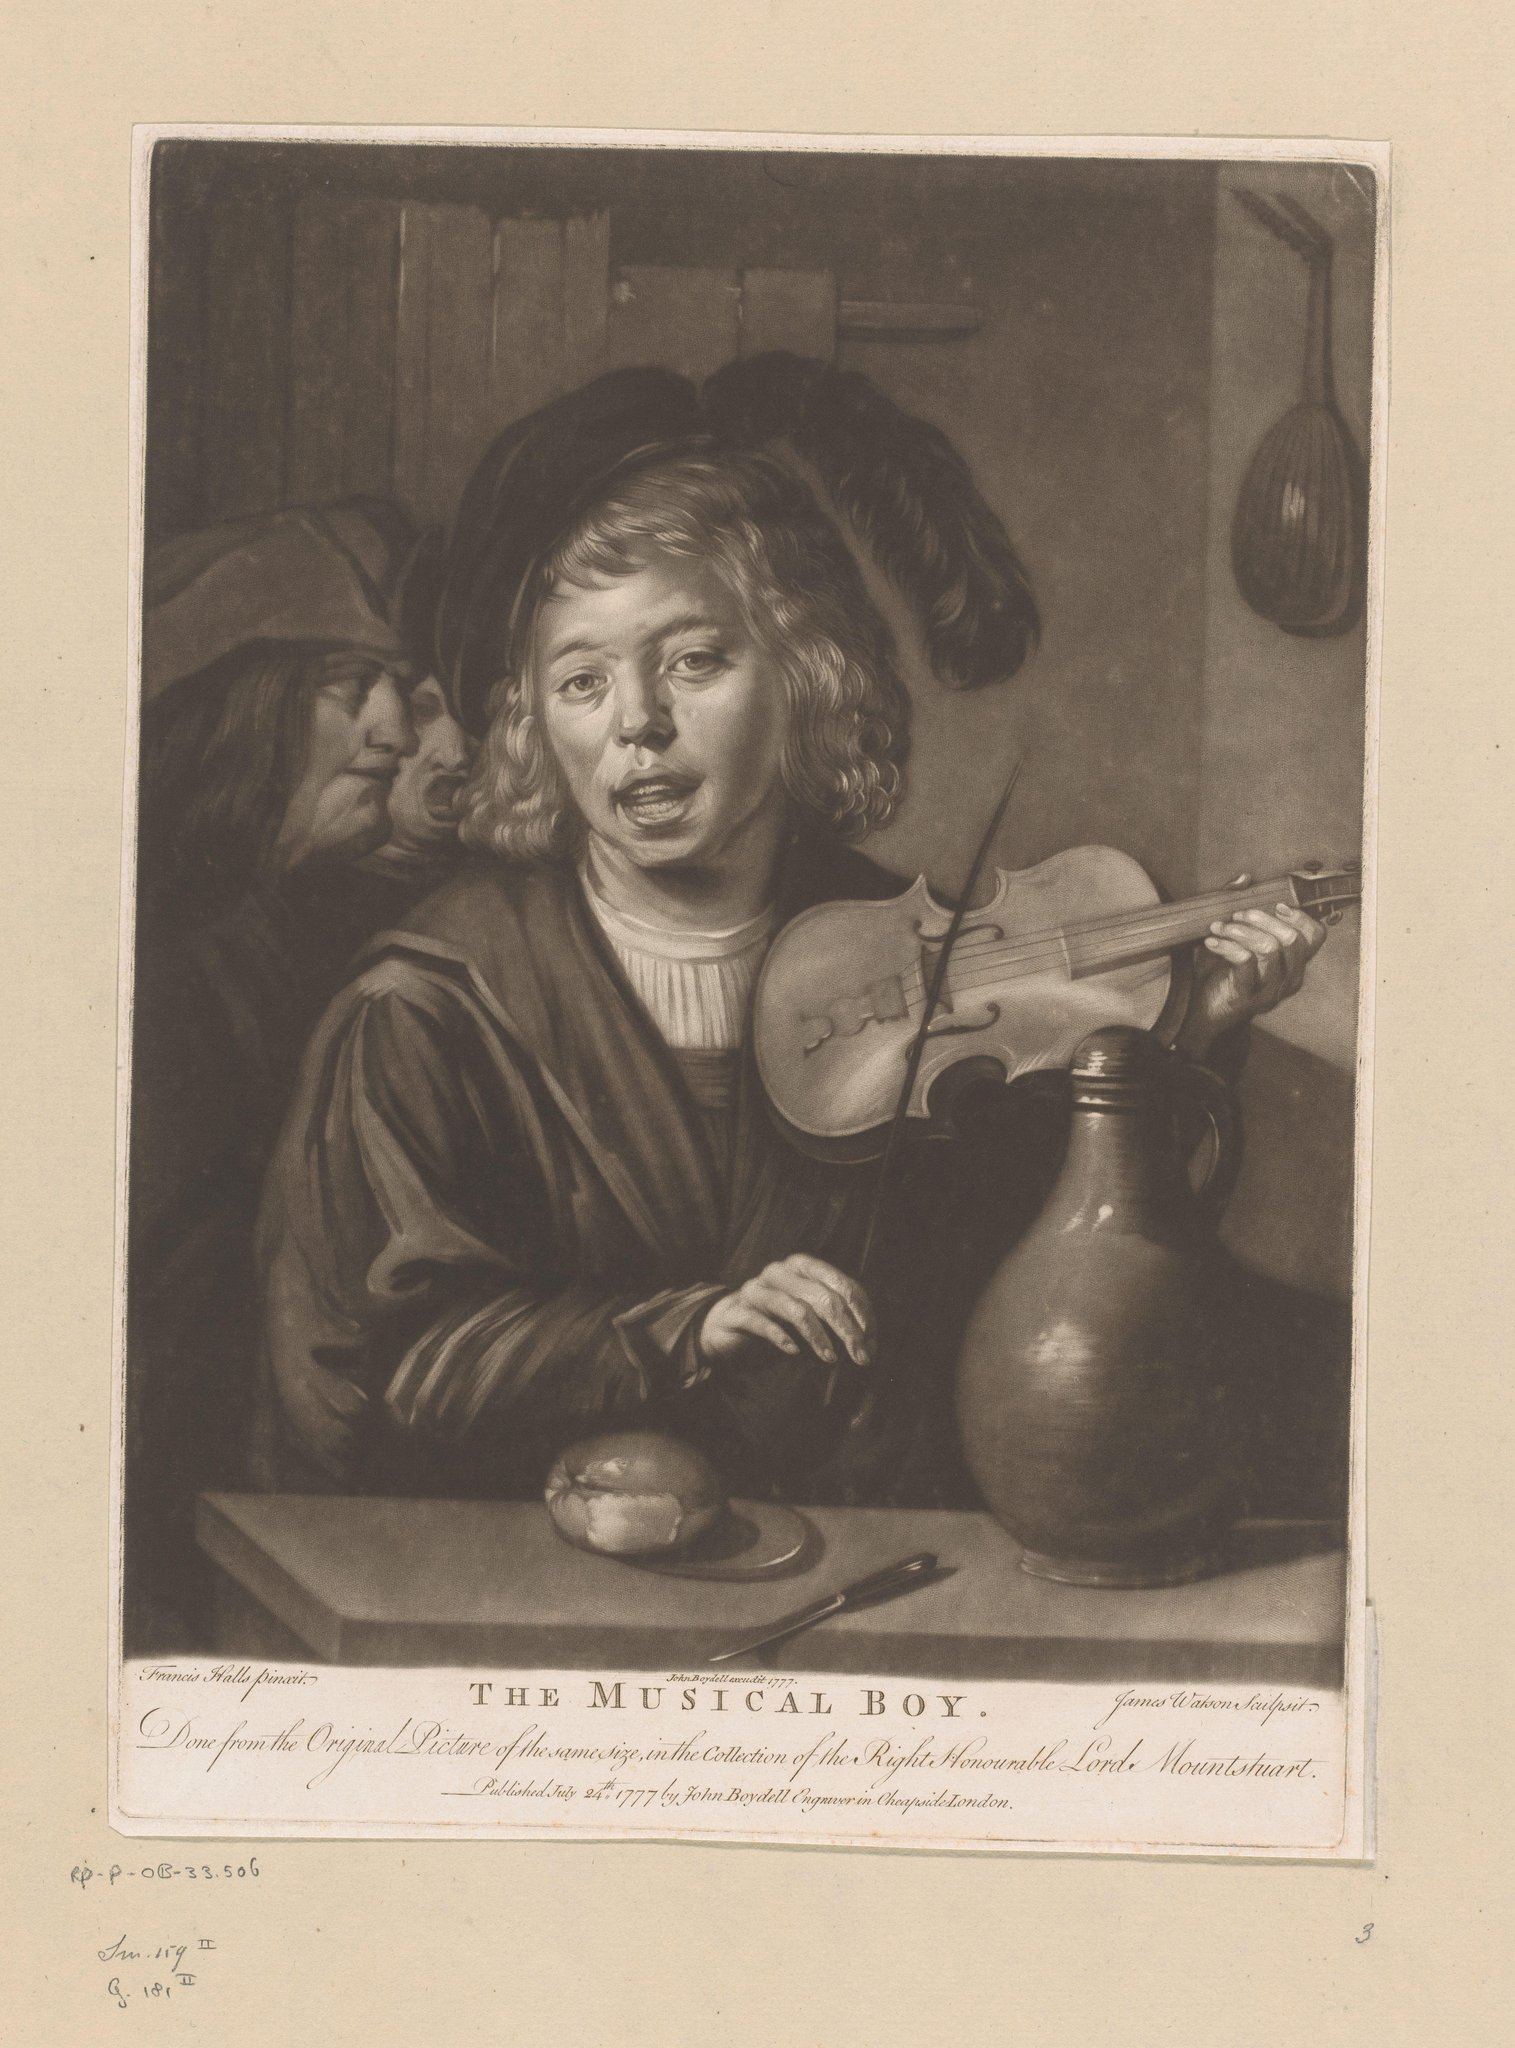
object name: print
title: The Musical Boy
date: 1777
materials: paper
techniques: mezzotint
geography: london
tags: violin, fiddle, vocal music, singing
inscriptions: collector's mark: Lugt 240